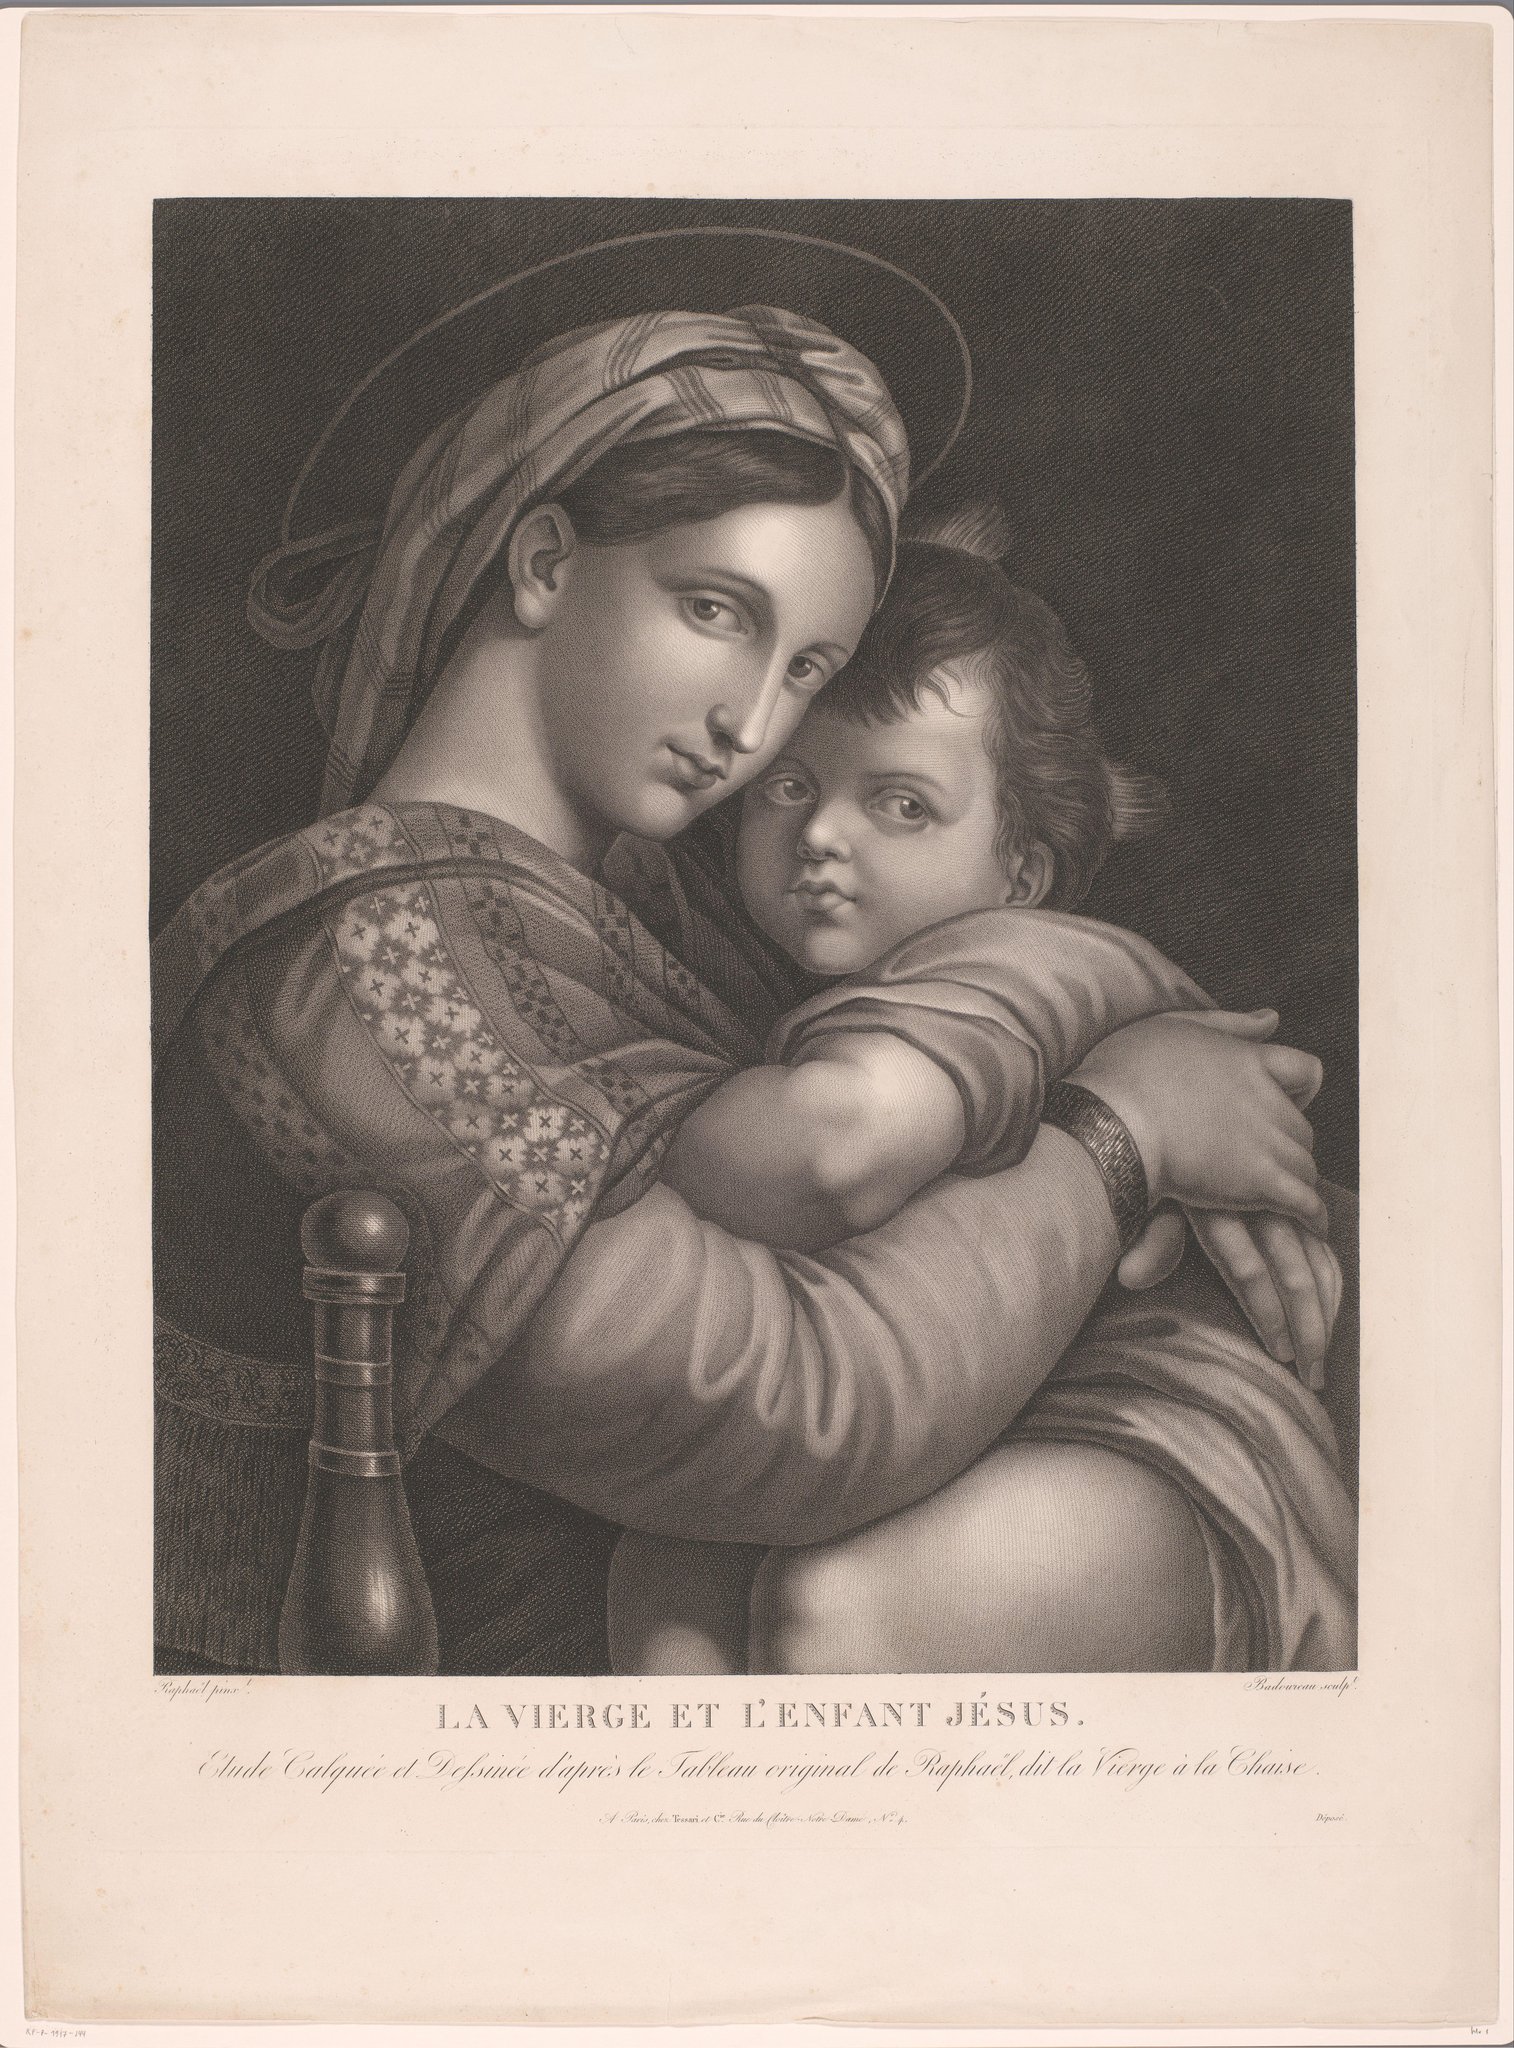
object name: print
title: Maria met Kind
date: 1819-1829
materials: paper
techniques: engraving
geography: paris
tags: madonna: i.e. mary with the christ-child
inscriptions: : ‘Déposé.’, collector's mark: Lugt 2228